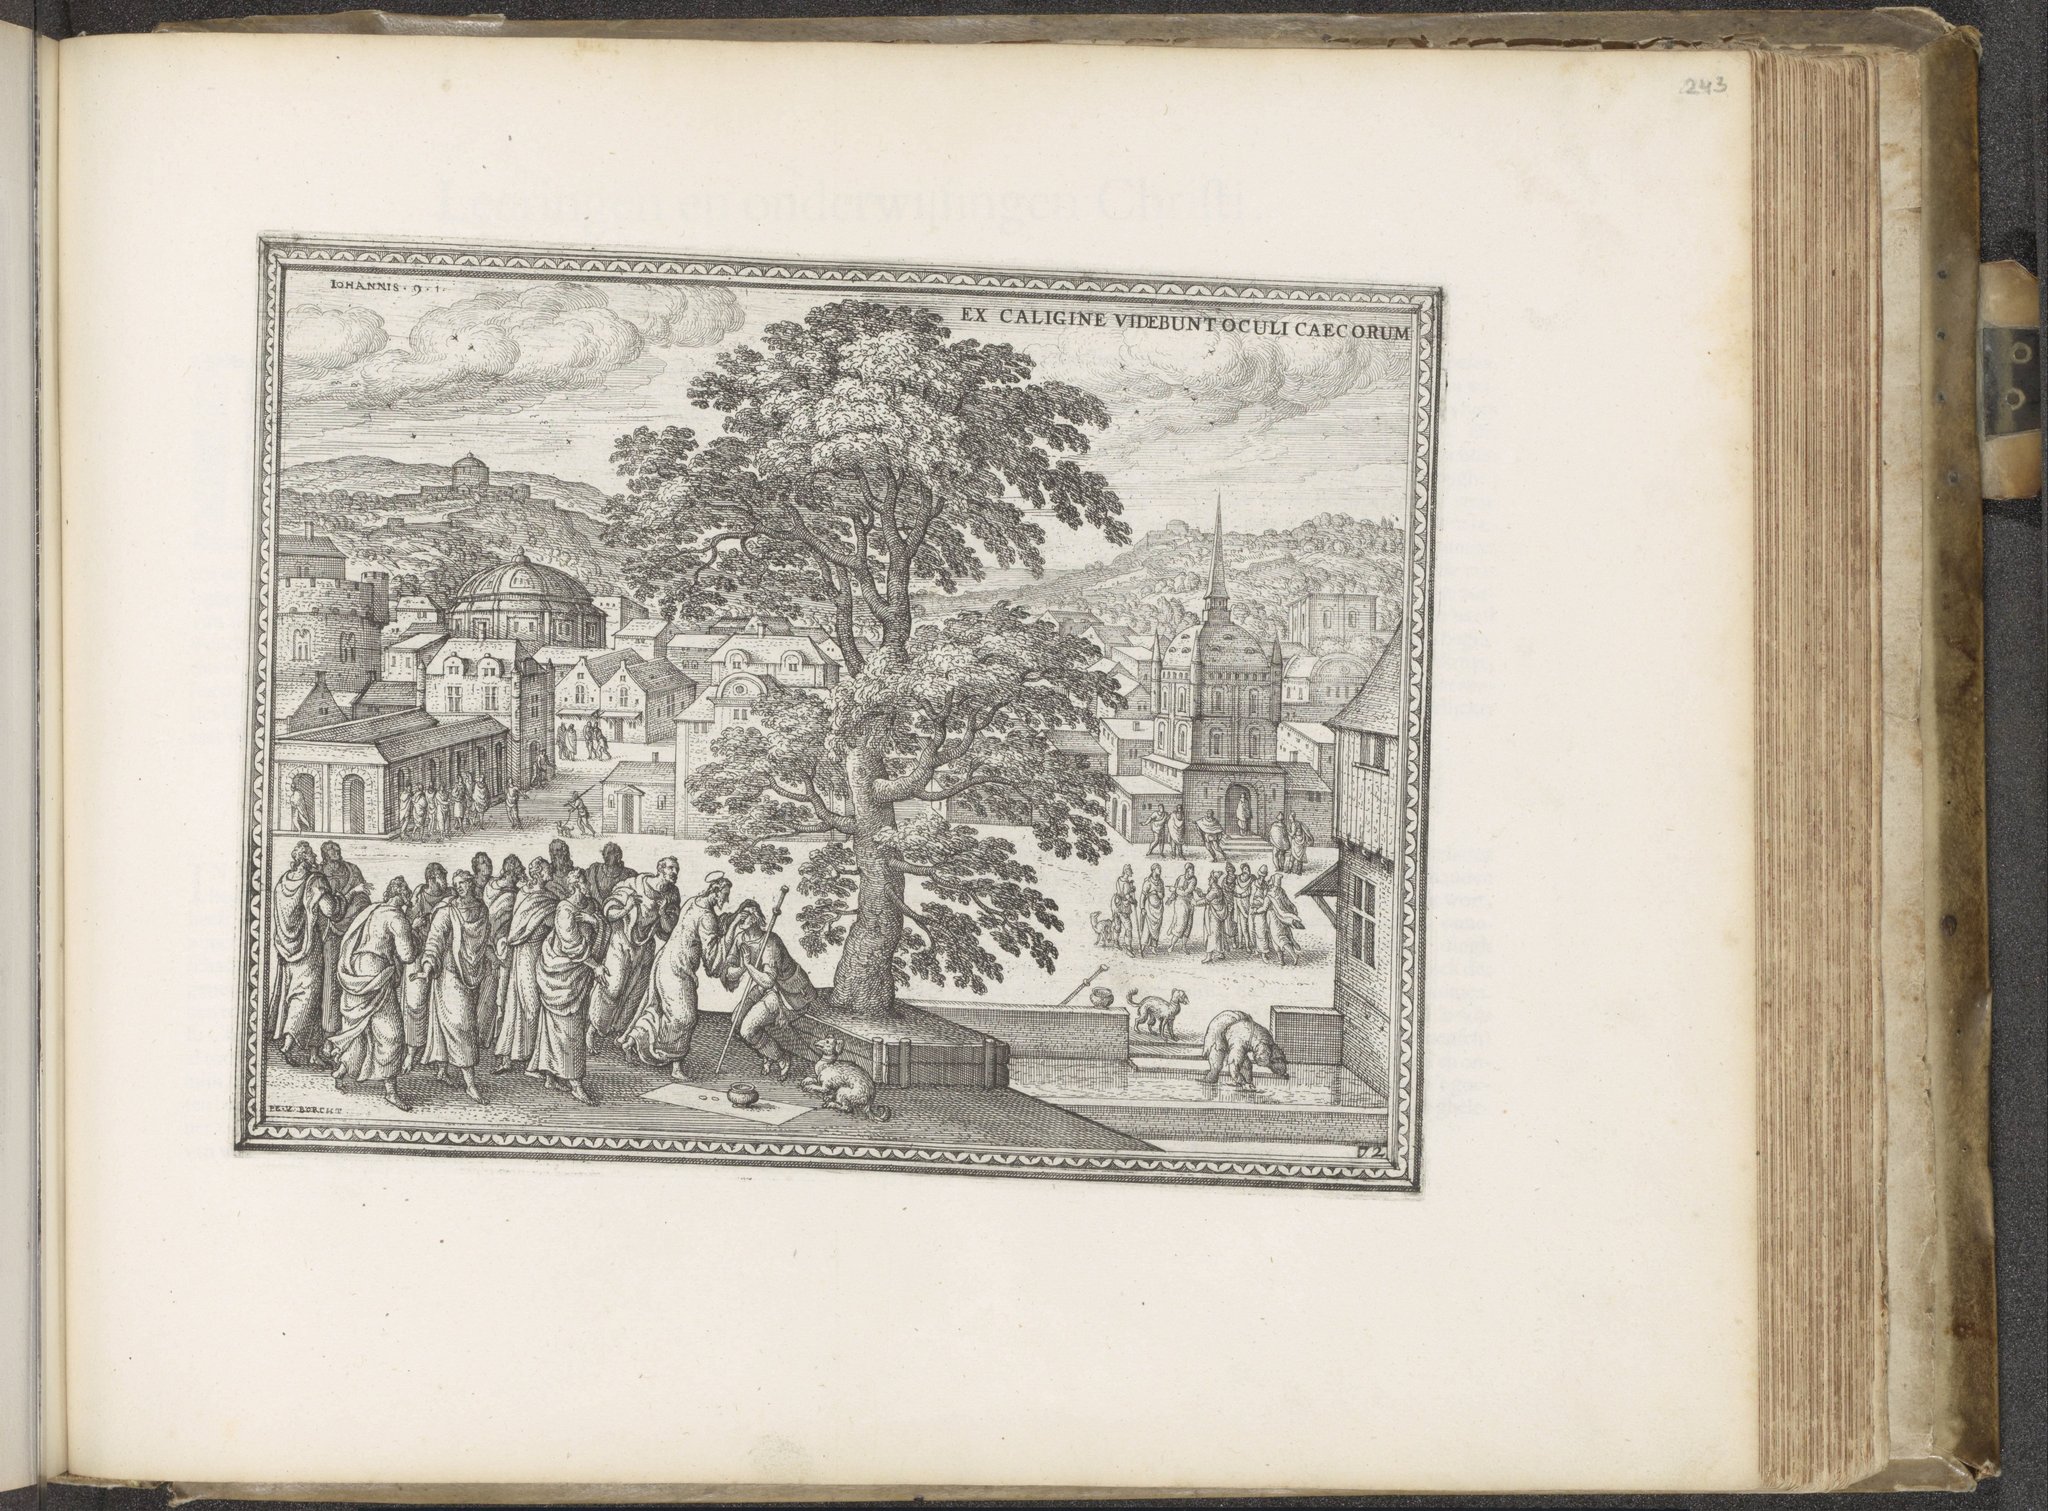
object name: album leaf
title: Ex caligine videbunt oculi caecorum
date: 1582-1593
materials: paper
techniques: etching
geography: amsterdam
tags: the man born blind washes his eyes in the pool of siloam, and throws away his stick, healing of a man born blind: christ touches his eyes with an 'ointment' of dust and spittle (john 9)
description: Stadsgezicht met de genezing van een blinde door Christus. Onder een boom zit een blinde man met zijn hond. De twaalf apostelen kijken toe hoe Christus slijk op de ogen van de man wrijft. De man is genezen als hij zich de modder uit de ogen gewassen heeft (Joh. 9:1). De prent maakt deel uit van een album.